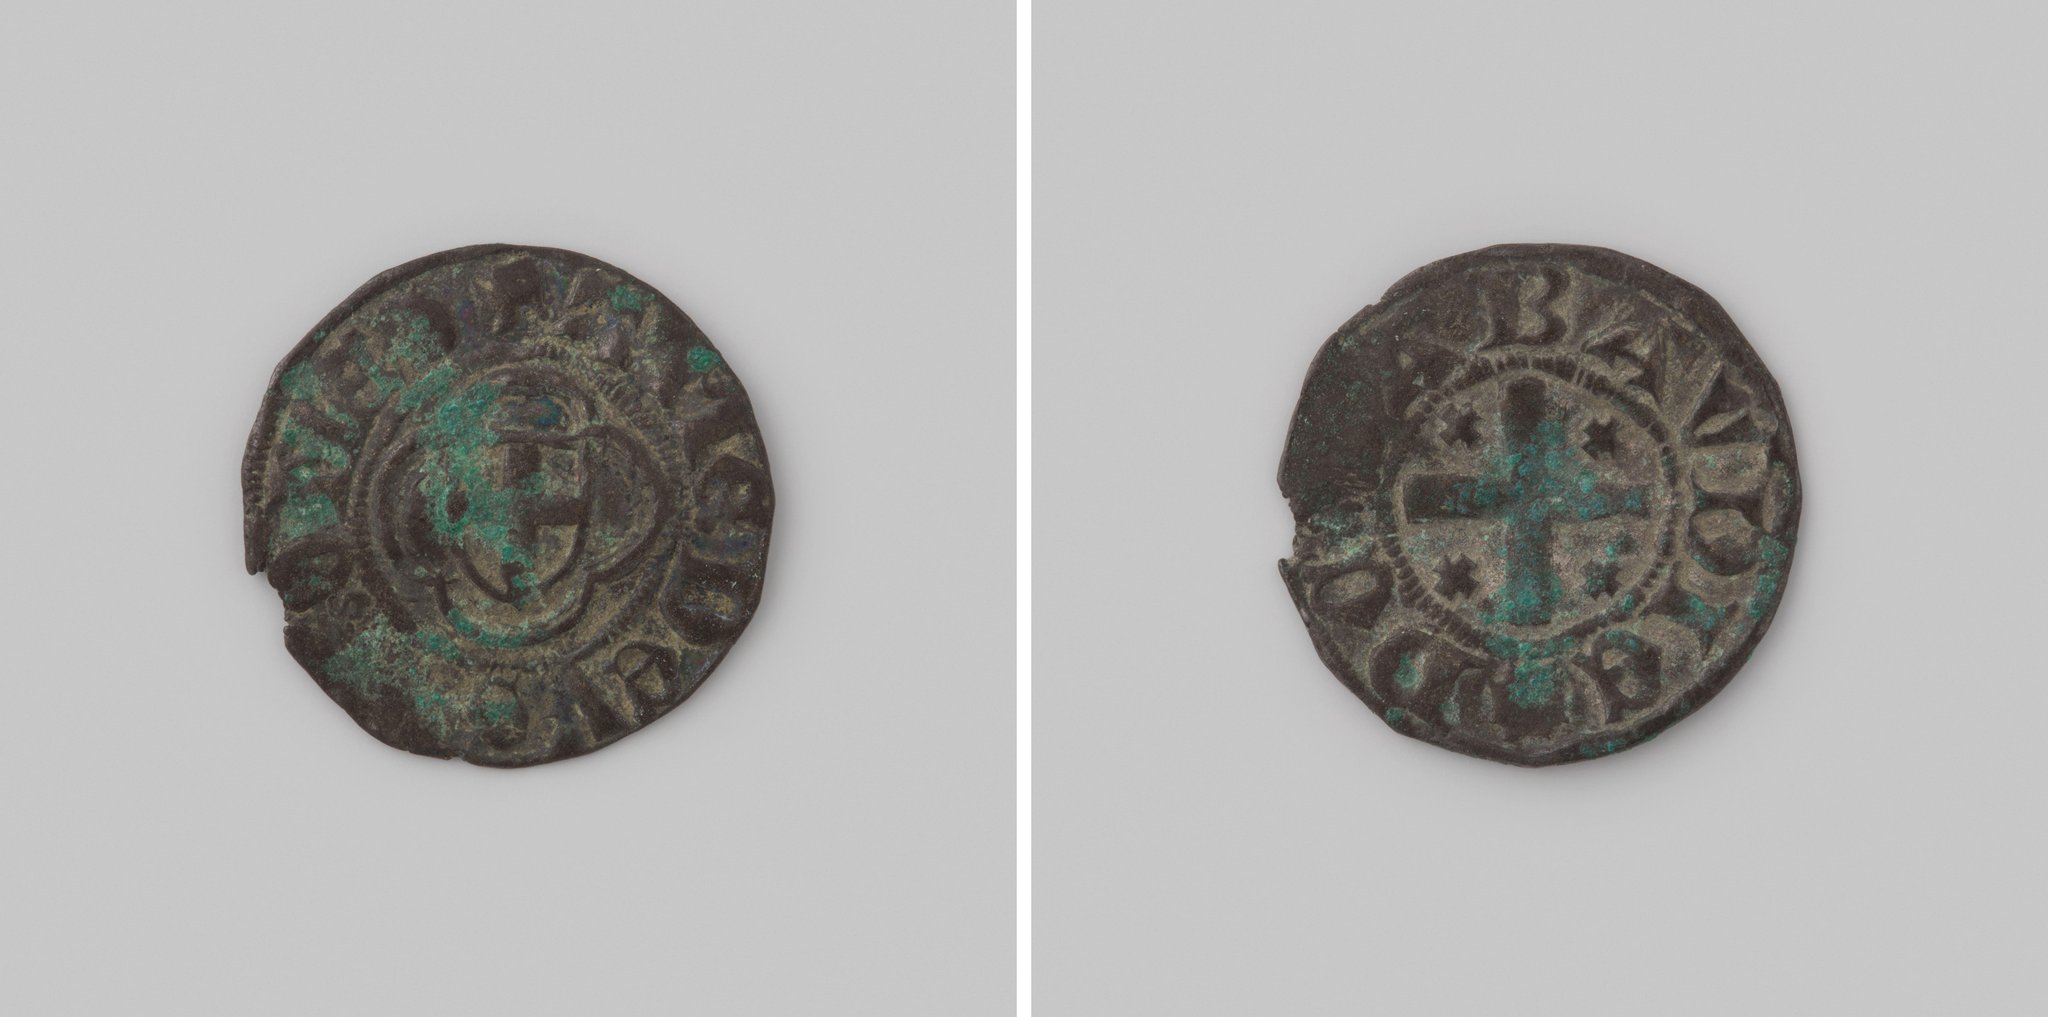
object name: coin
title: Savoye, bianchetto, Amedeo VIII, 1391-1439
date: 1391-1439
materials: silver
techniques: striking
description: Zilveren munt. Voorzijde: binnen een vierpas het wapenschild van Savoye. Keerzijde: kort kruis met in de hoeken stippen.